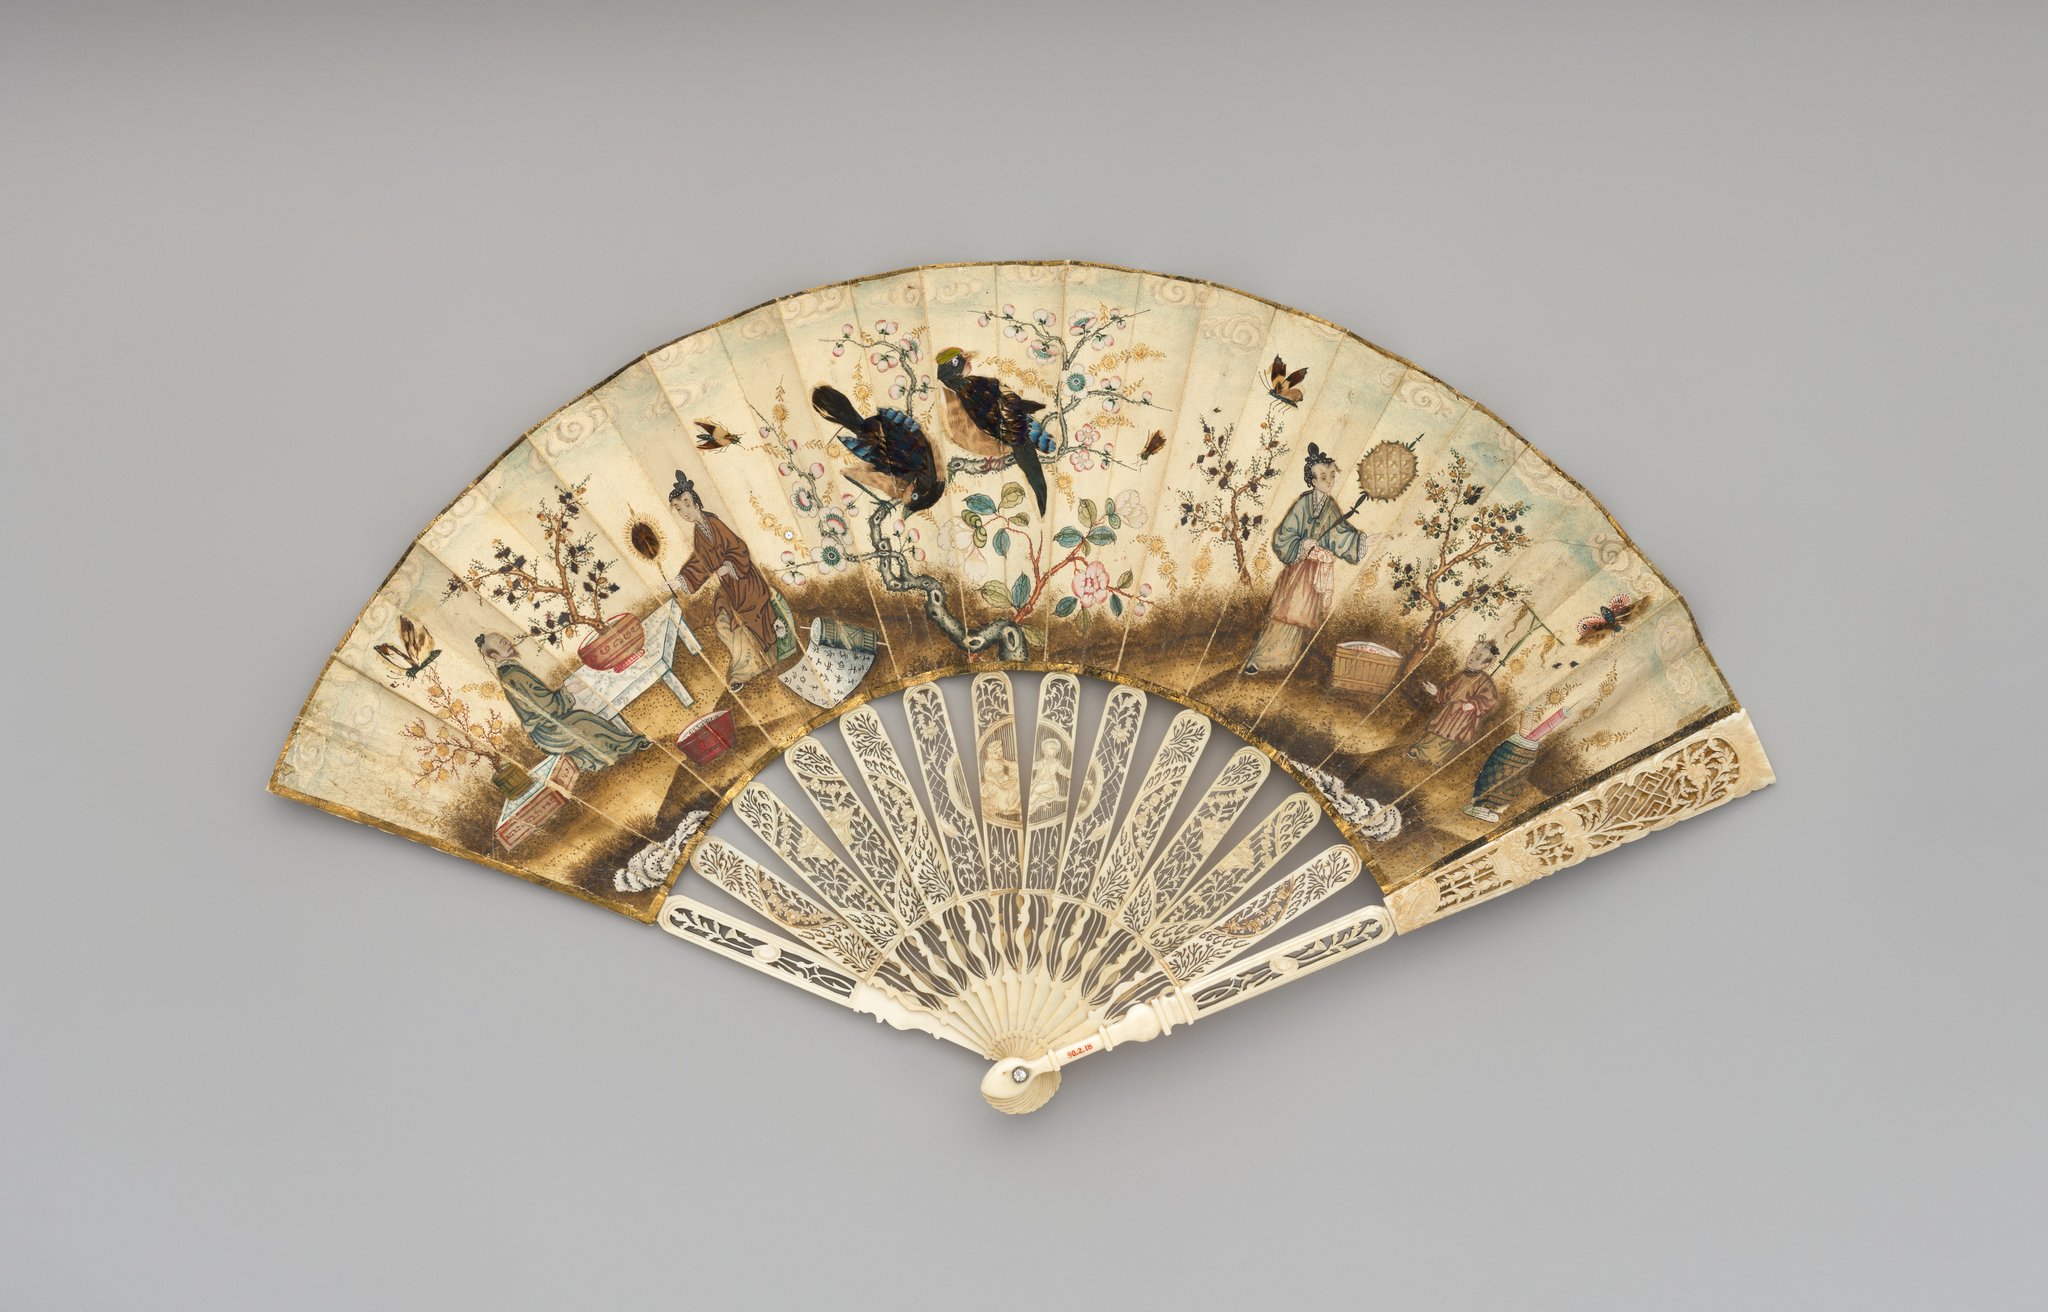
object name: fan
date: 1750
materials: feather, ivory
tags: birds,men,insects,butterflies